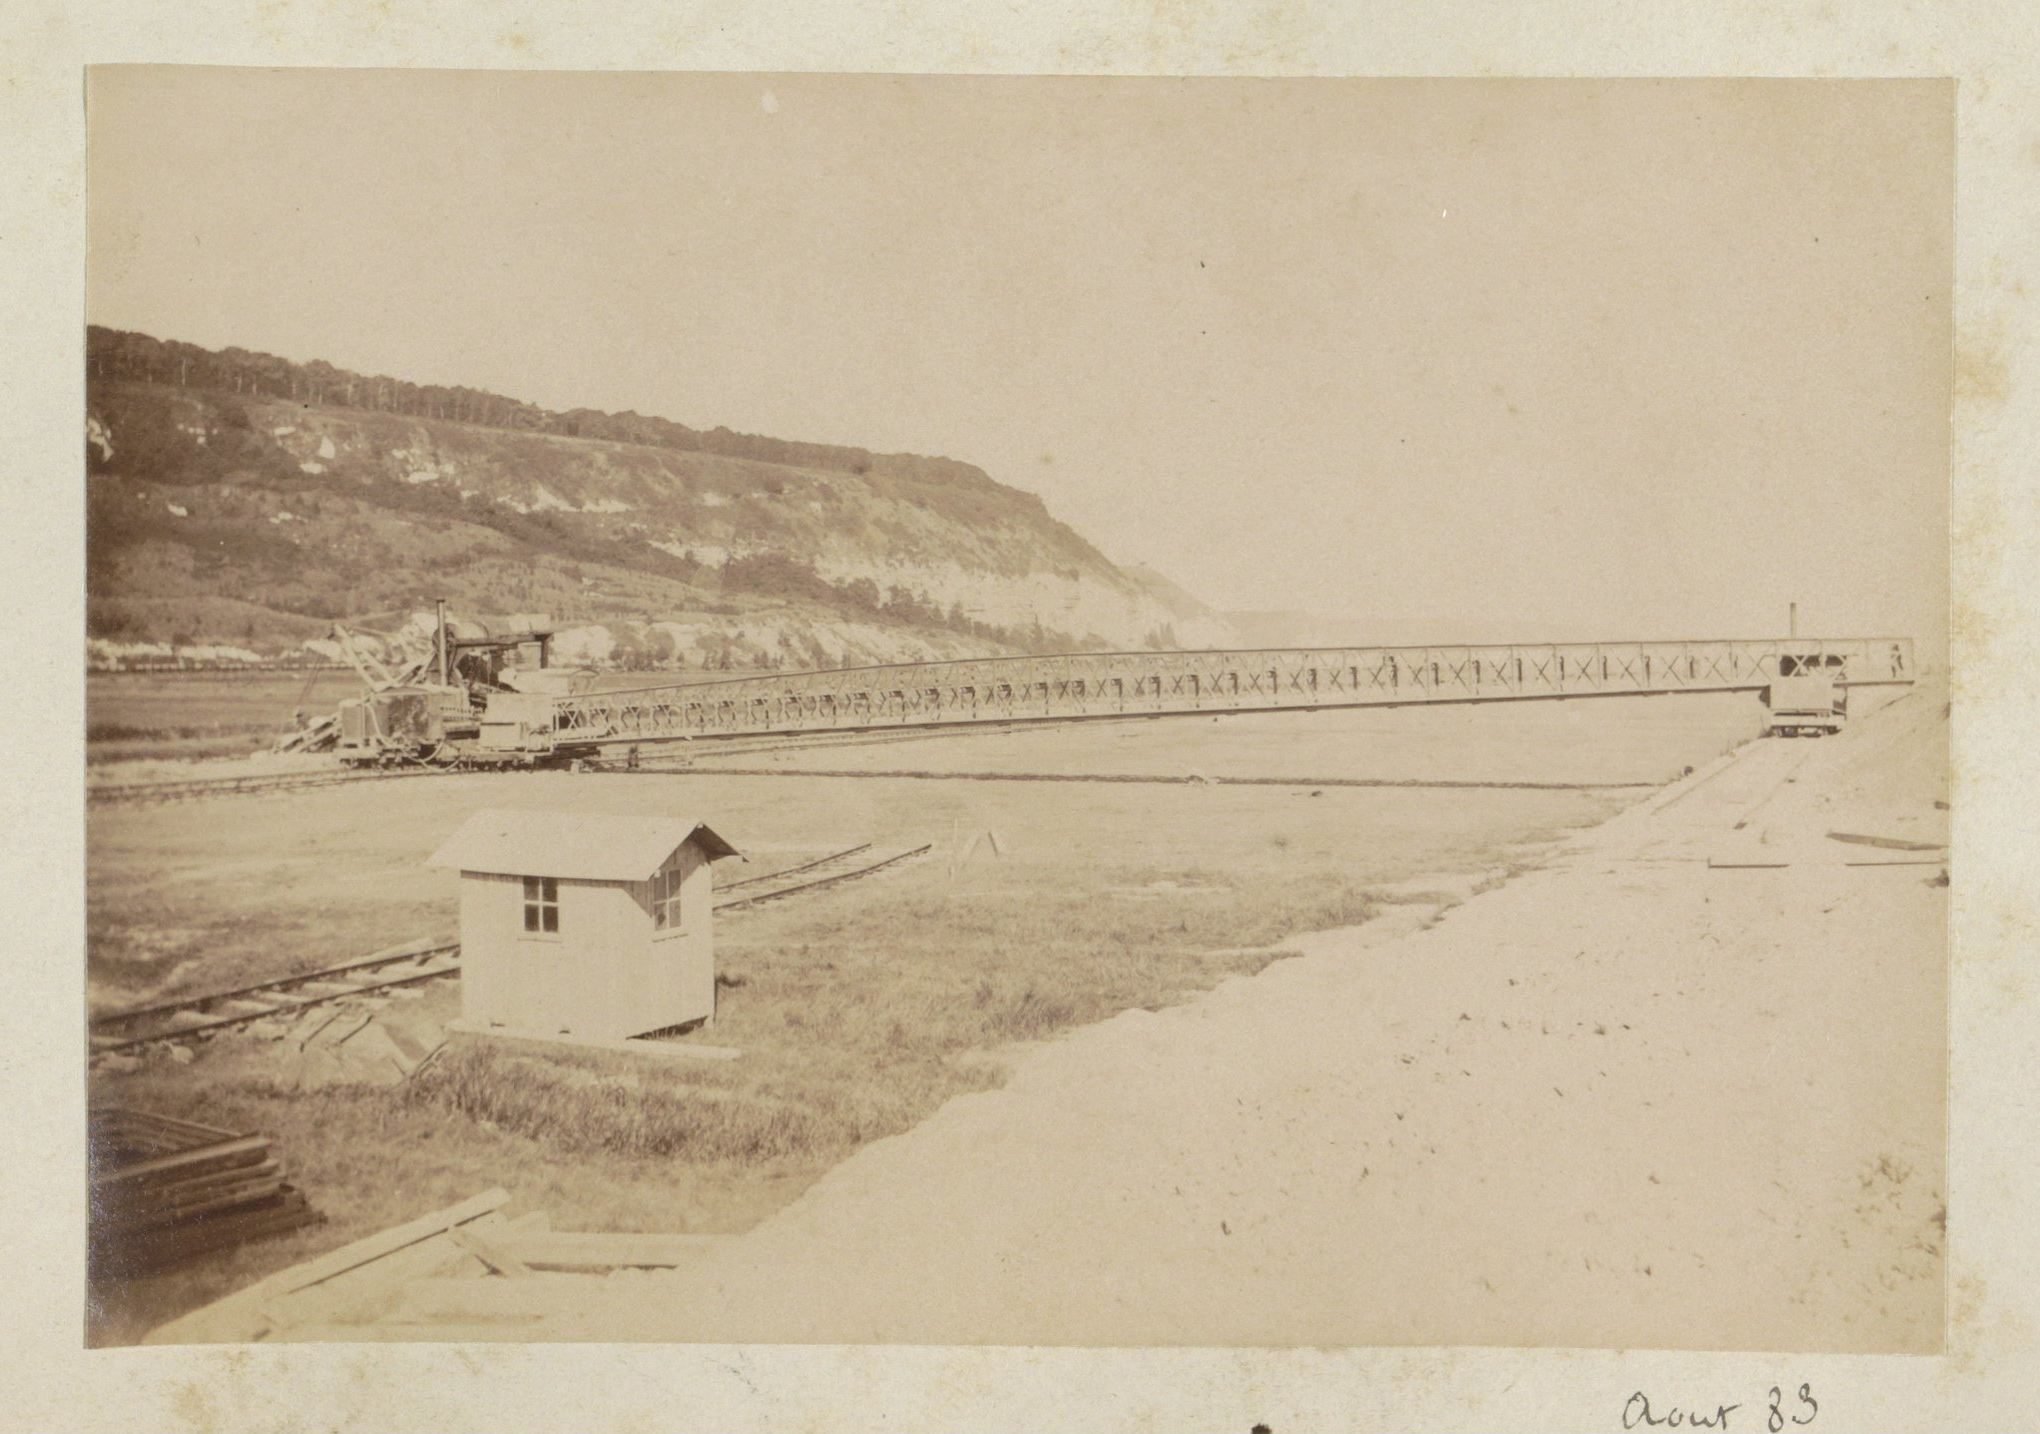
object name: photograph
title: Landschap in Frankrijk met (vermoedelijk) een graafmachine en een transportband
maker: Anonymous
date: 1808-1883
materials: photographic support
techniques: albumen print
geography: france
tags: machines, engines ~ crafts and industries, france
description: Onderdeel van Album van een Franse amateurfotograaf met opnames van familie, militairen, industrie, landschappen en bezienswaardigheden in Frankrijk.